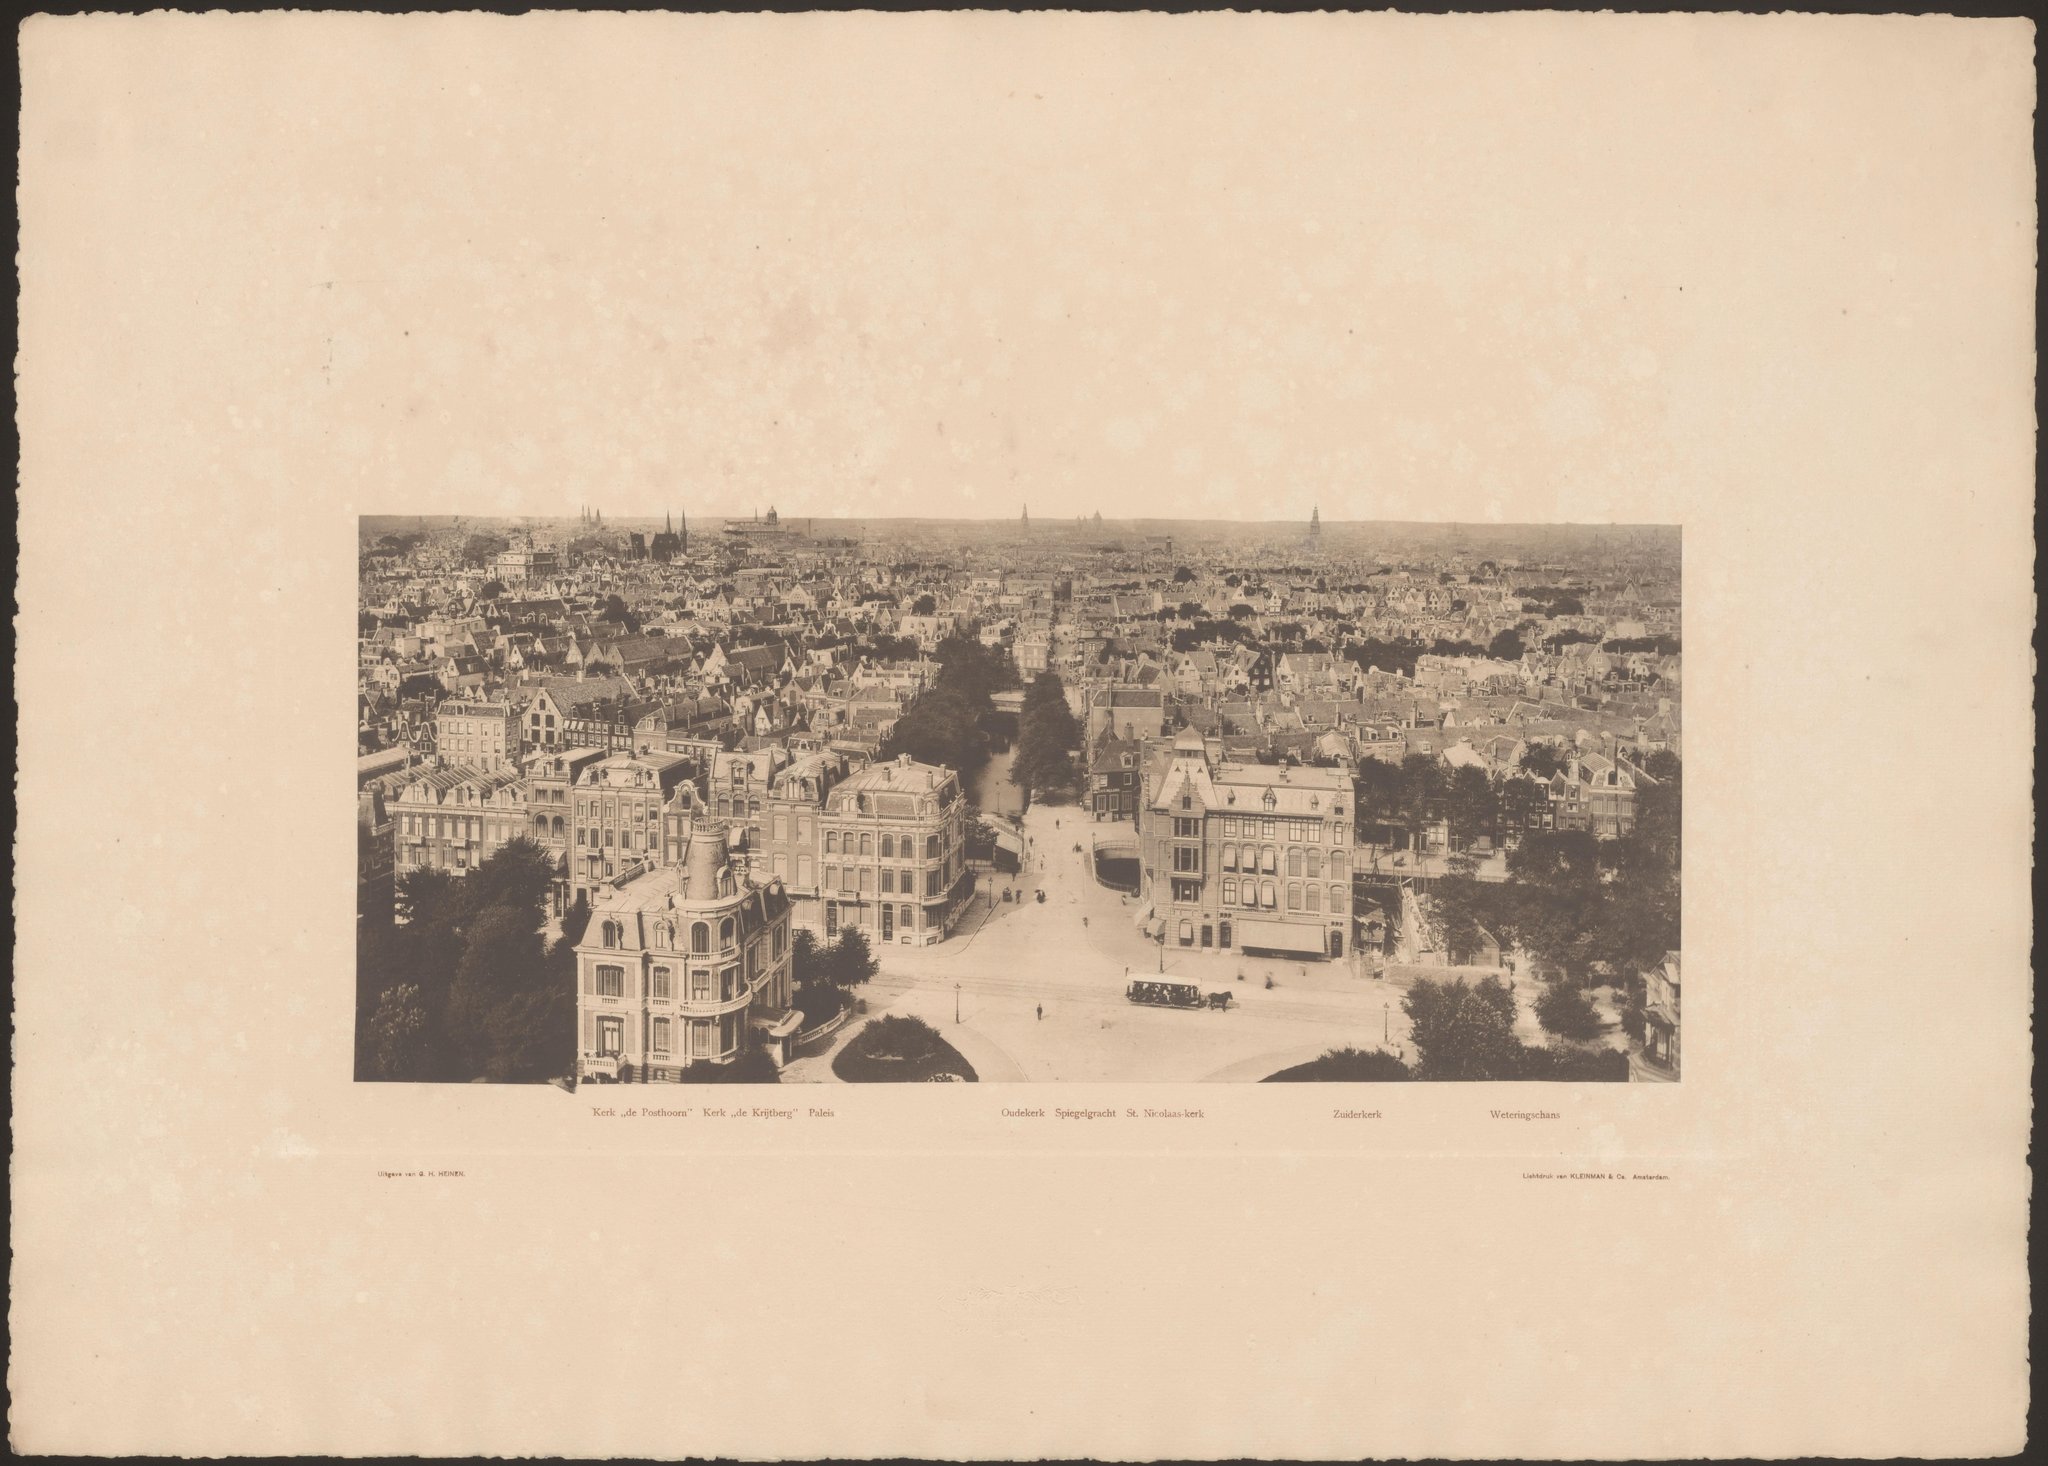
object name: photomechanical print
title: Gezicht op de Weteringschans en de Spiegelgracht vanuit het Rijksmuseum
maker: gerrit hendricus heinen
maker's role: painter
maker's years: 1851-1930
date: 1892-1930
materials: paper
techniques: photograph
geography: amsterdam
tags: canal, bridge in city across river, canal, etc., street, prospect of city, town panorama, silhouette of city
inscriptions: check stamp: ‘G.H. Heinen Amsterdam / Schilder & Fotograaf’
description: Onderwerpsrubriek binnen de Atlas Amsterdam: Panorama's en verzamelprenten.